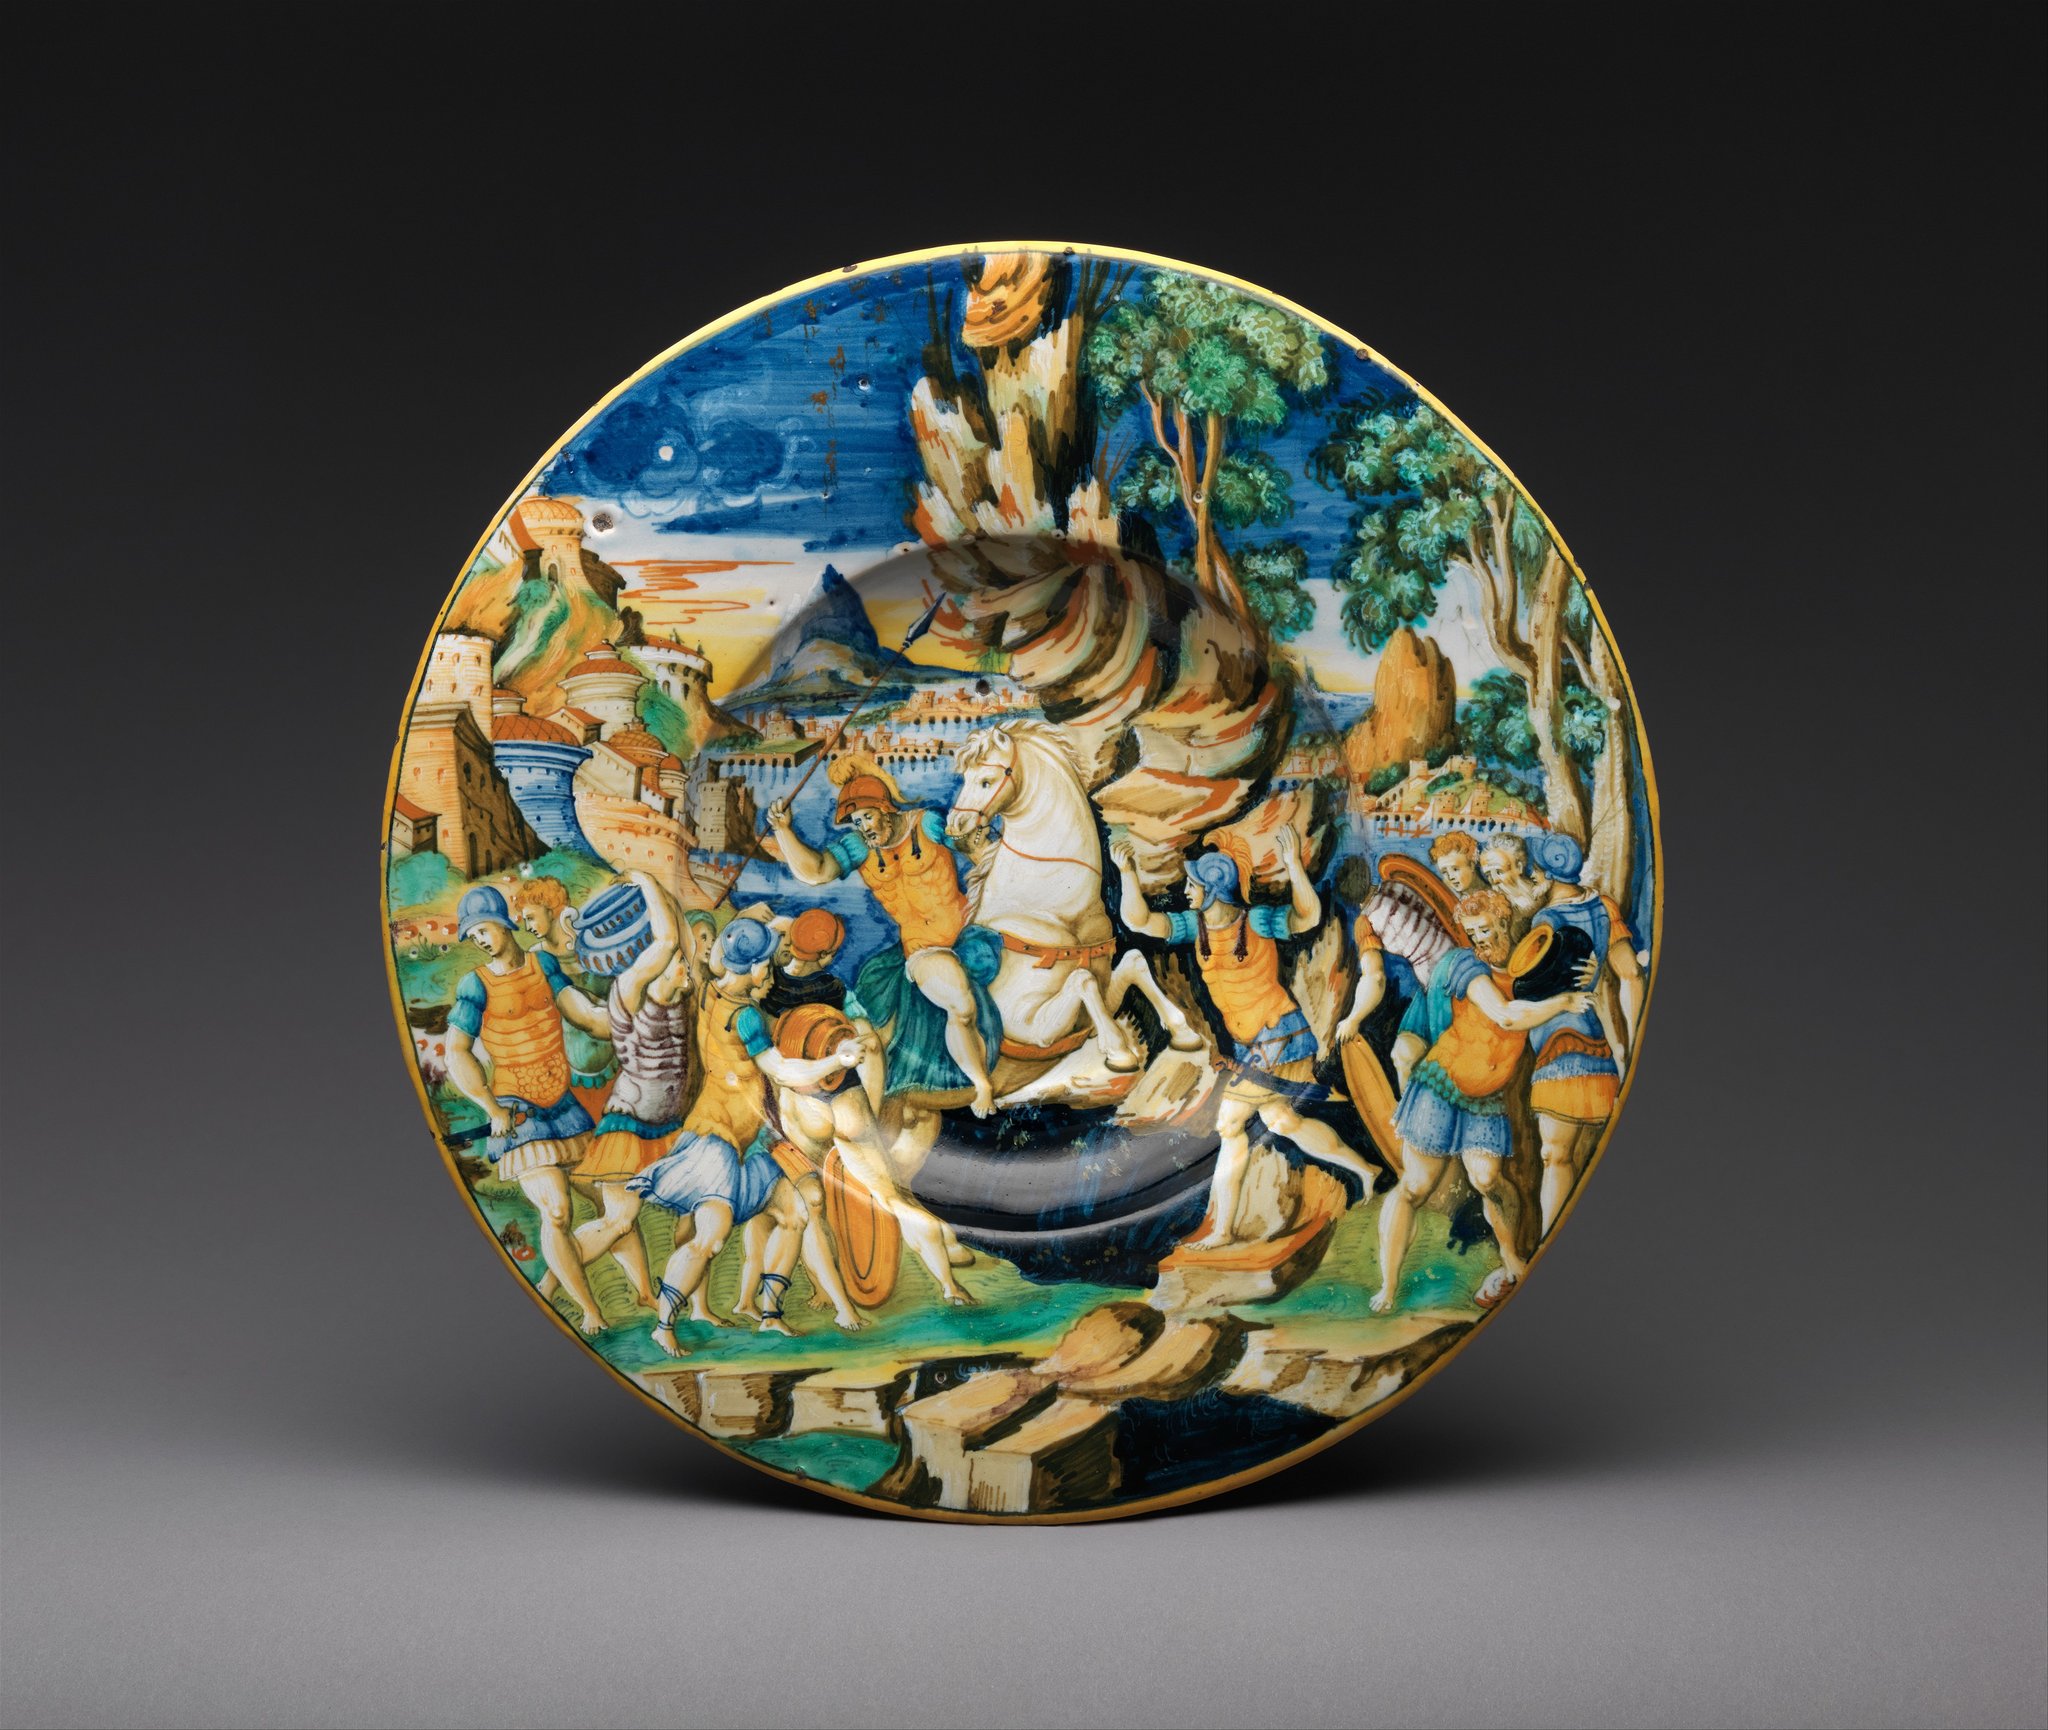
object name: dish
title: Dish with The Heroism of Marcus Curtius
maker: guido de merlino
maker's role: maker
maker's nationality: italian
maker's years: 1518-1558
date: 1542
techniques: maiolica, glazing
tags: men,horses